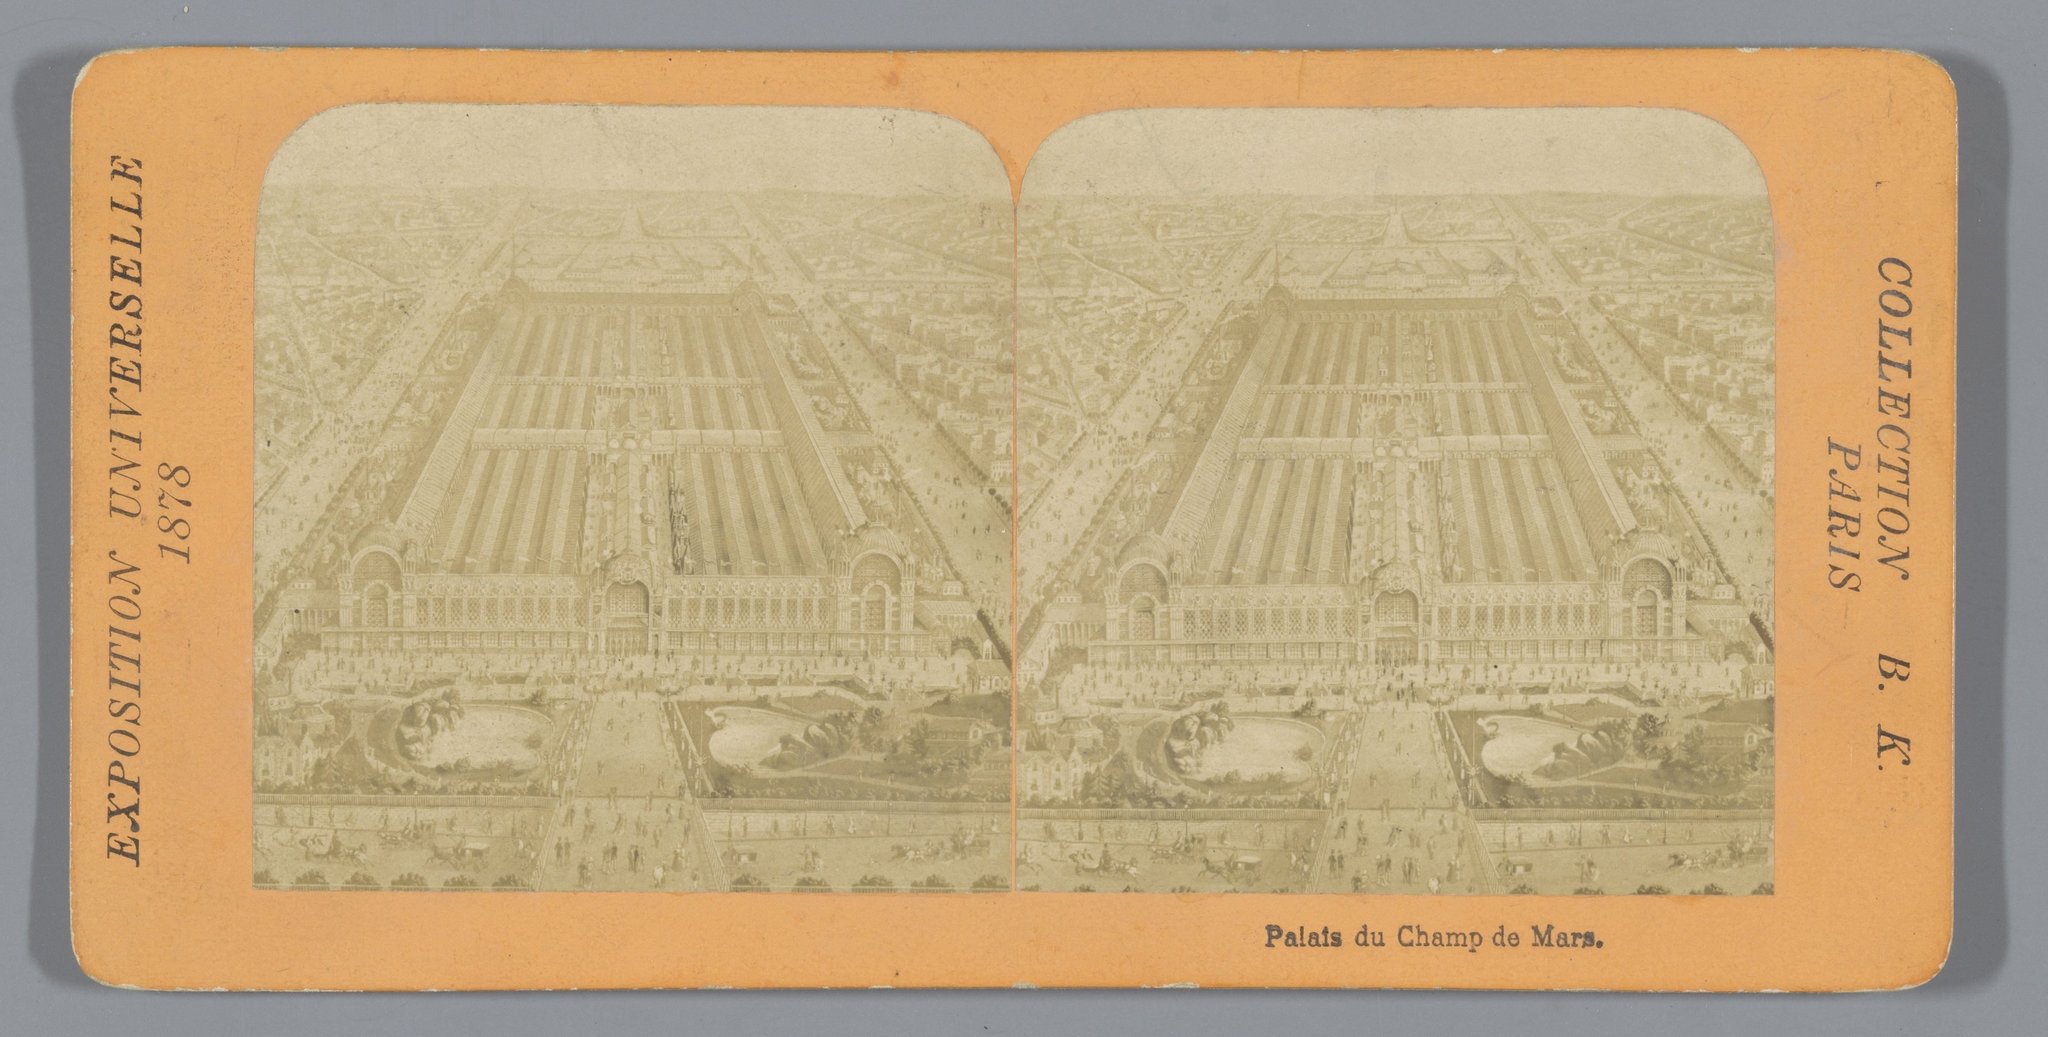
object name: stereograph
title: Palais du Champ de Mars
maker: adolphe block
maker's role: publisher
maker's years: 1829-1918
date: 1878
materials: cardboard, paper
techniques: albumen print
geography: paris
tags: world fair, world exhibition, palace, paris